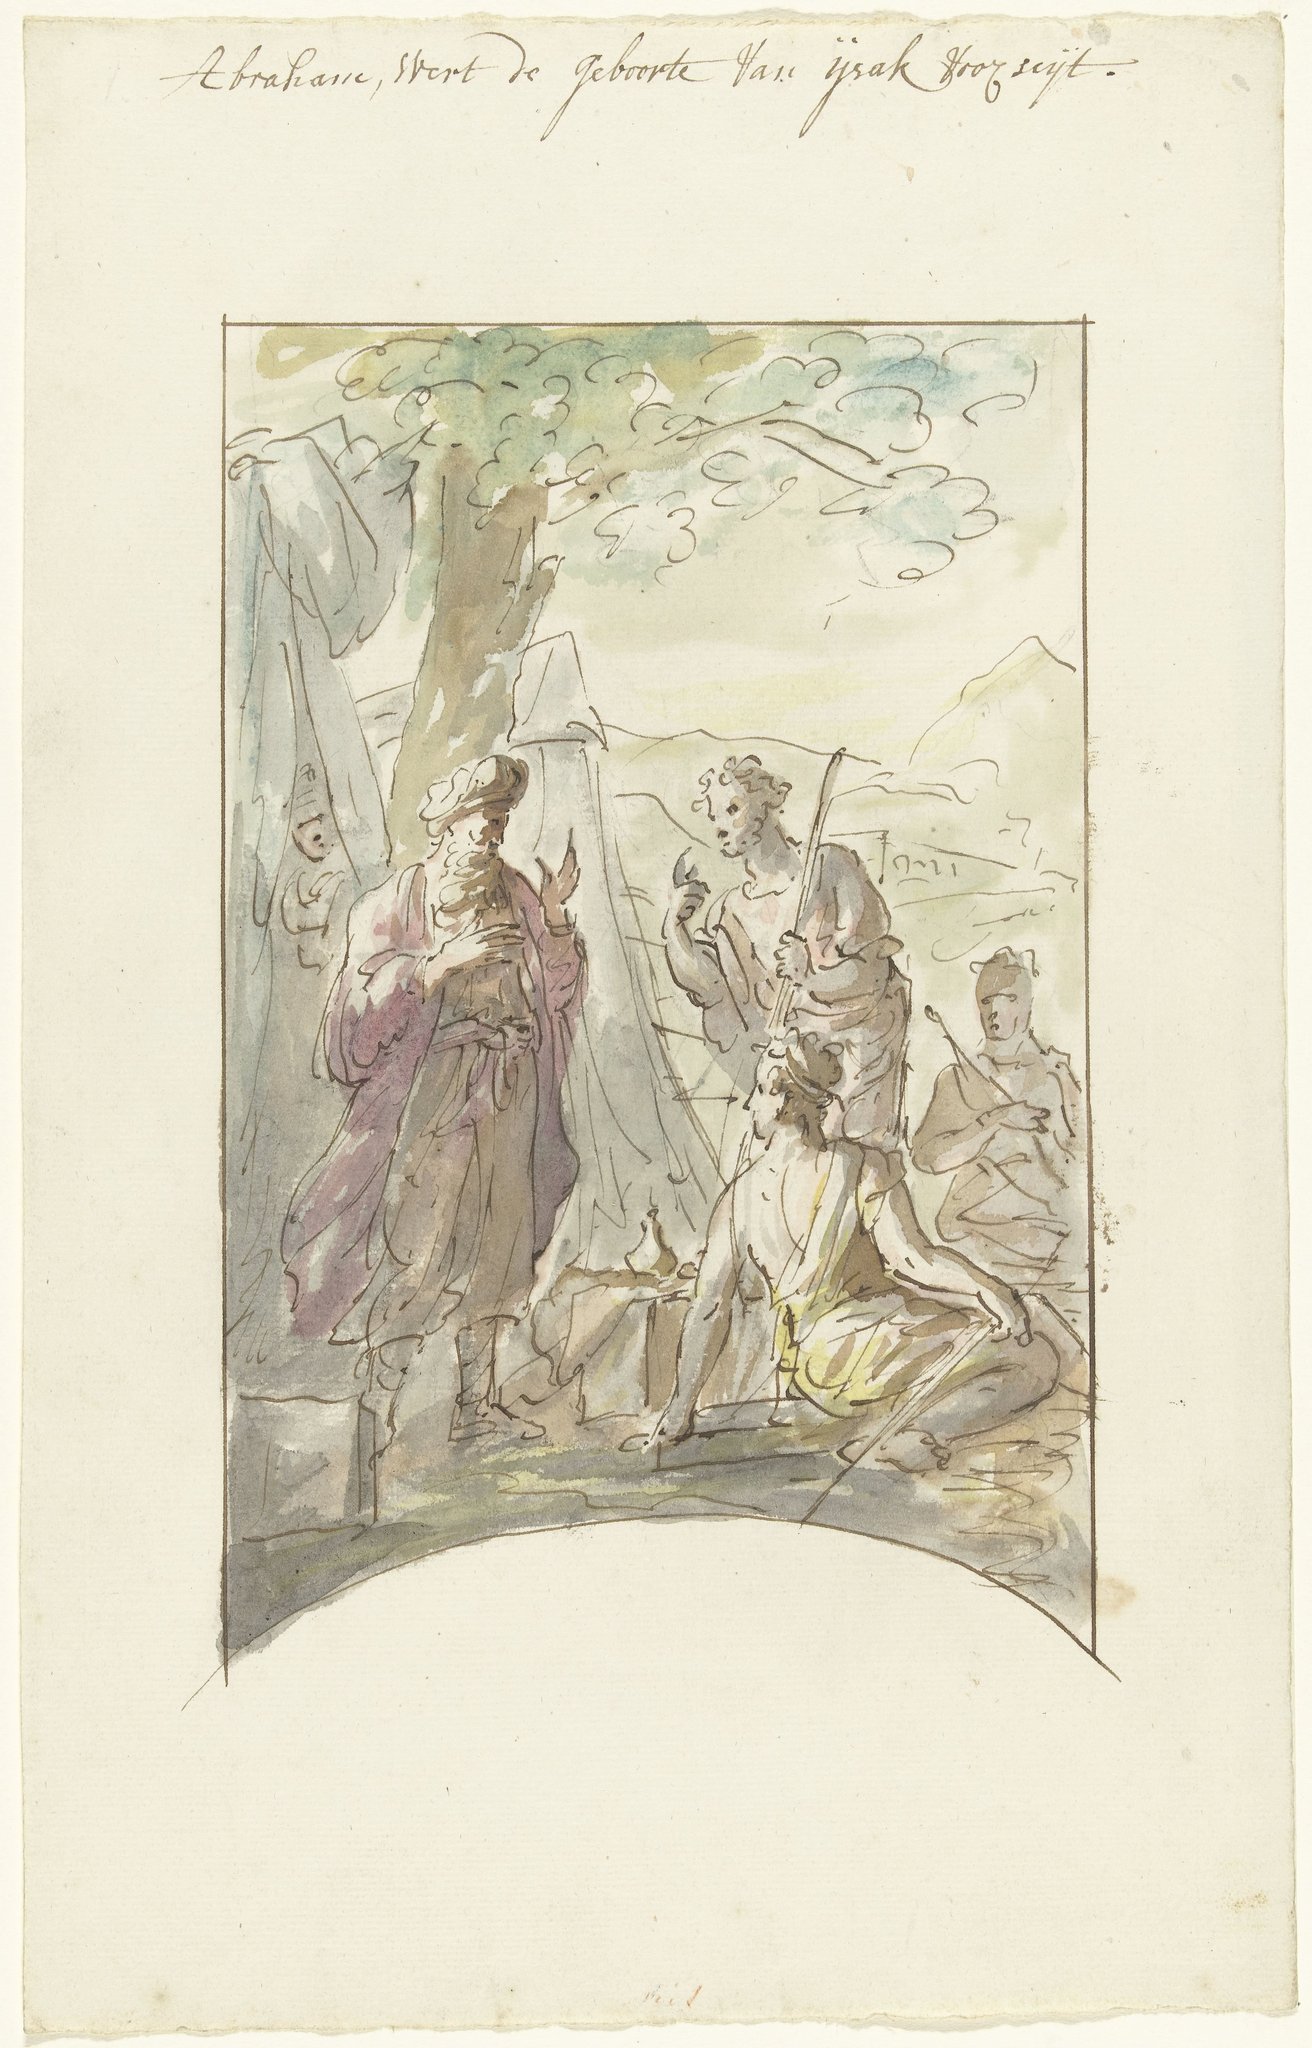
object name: design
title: Abraham wordt de geboorte van een zoon voorspeld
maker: elias van nijmegen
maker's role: draughtsman, painter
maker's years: 1667-1755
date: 1677-1755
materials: ink, paper, pencil, watercolor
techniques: brush, pen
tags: the promise of a son is renewed; sarah, overhearing it, laughs incredulously